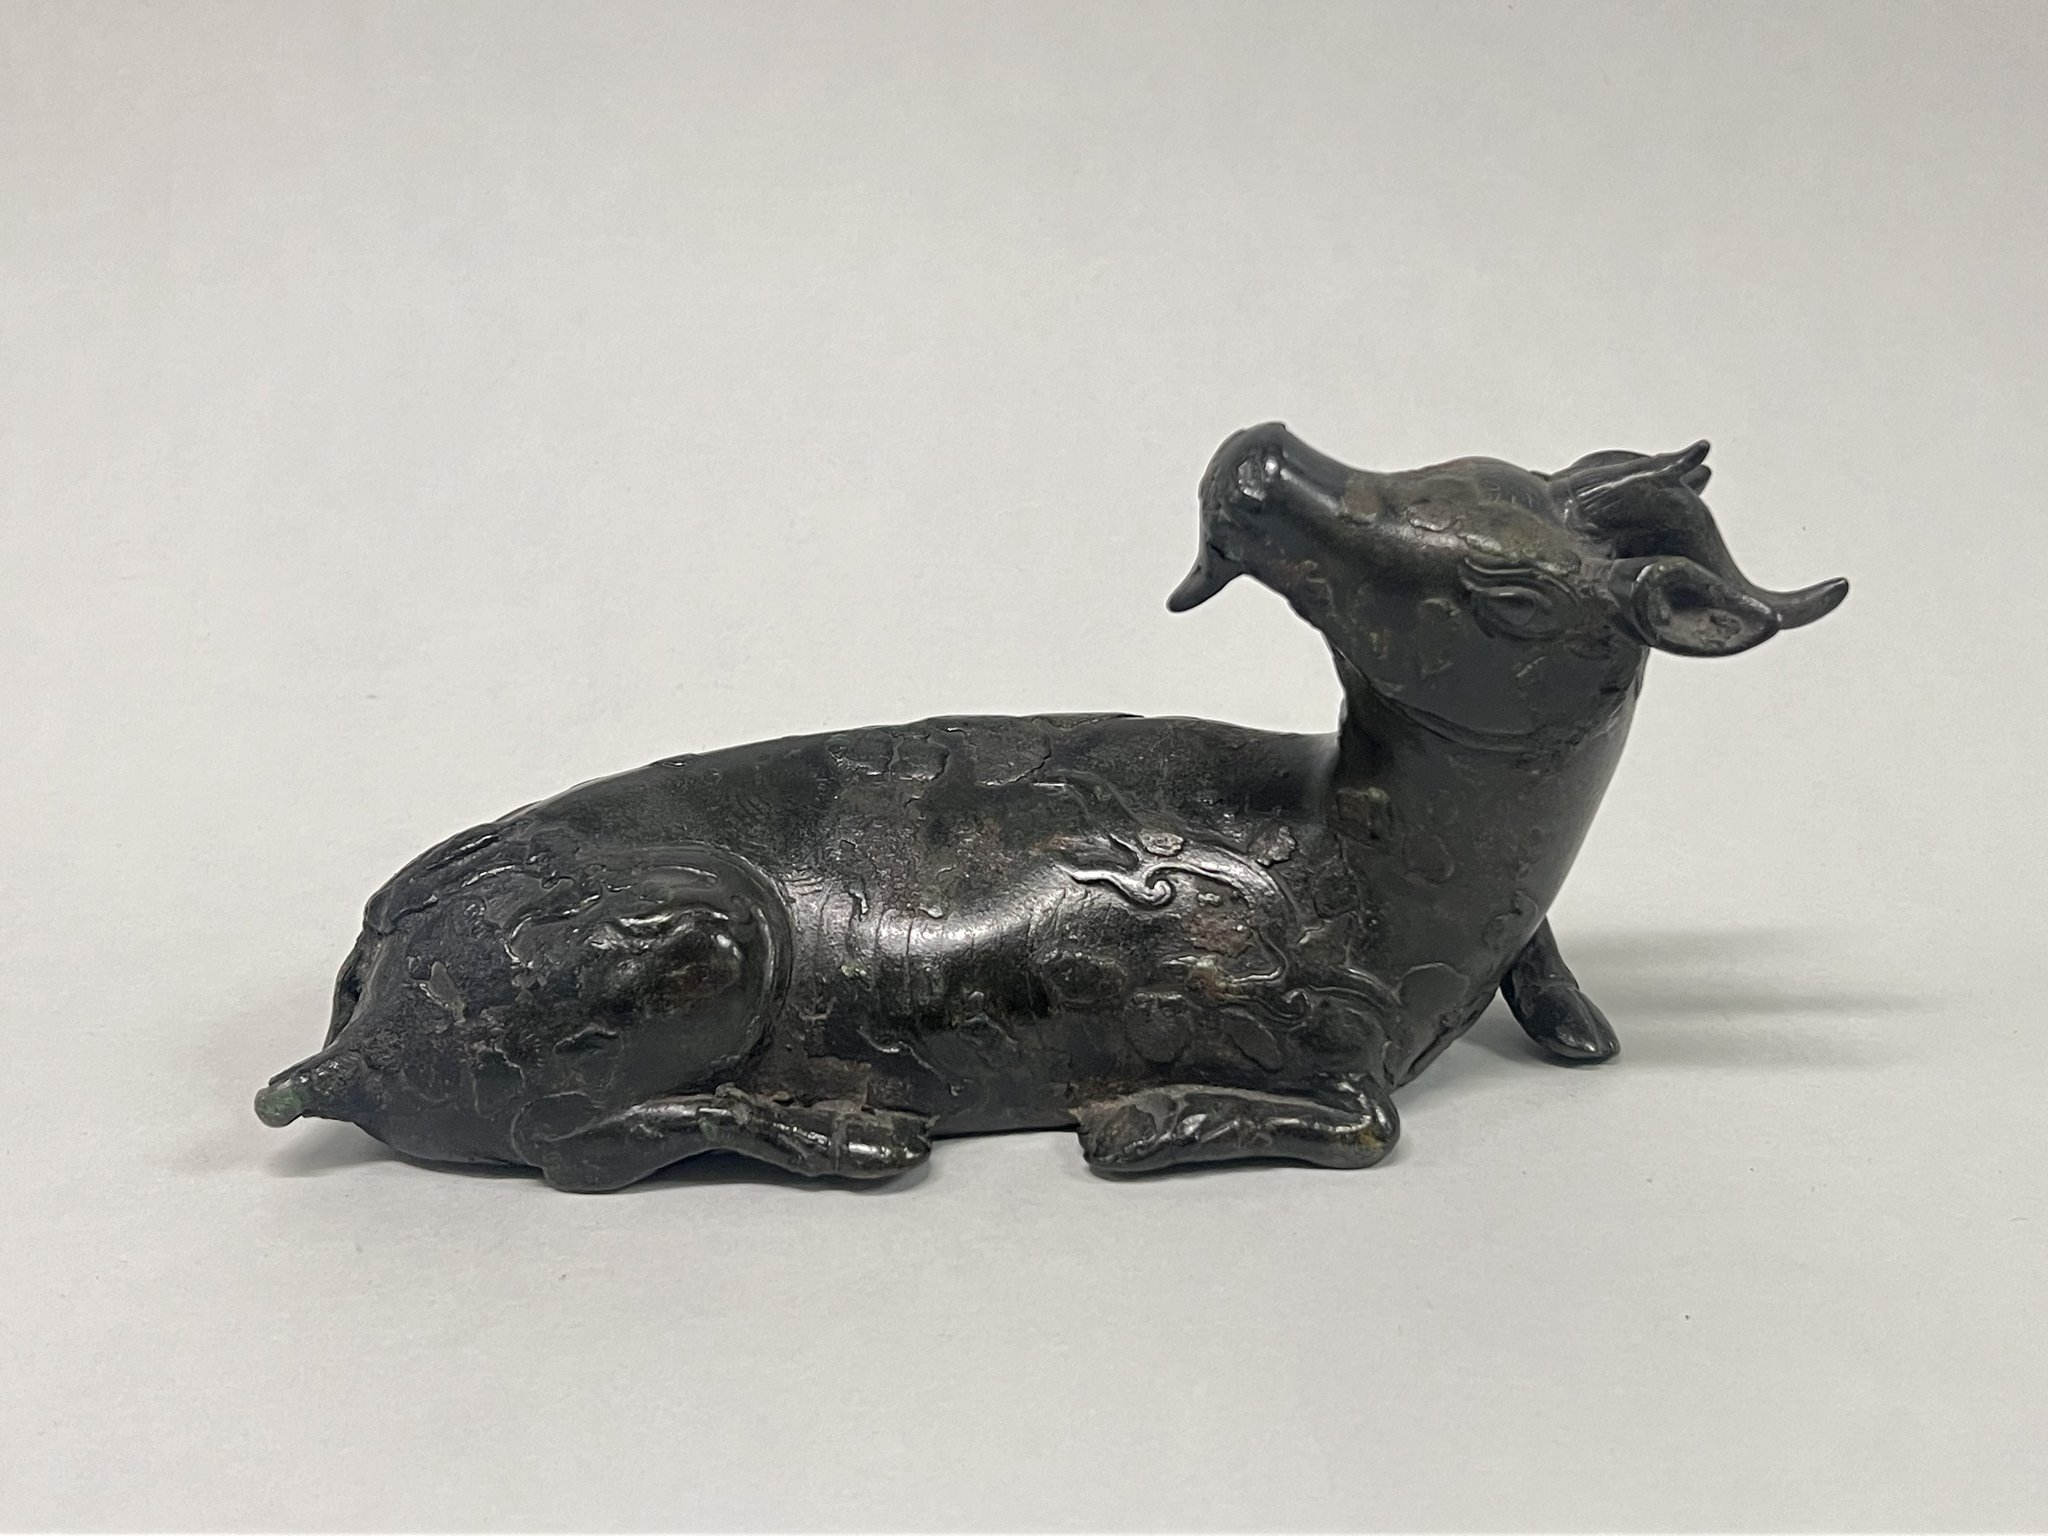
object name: figure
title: Recumbent Figure of Unicorn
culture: chinese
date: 1701-1800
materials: bronze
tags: unicorns